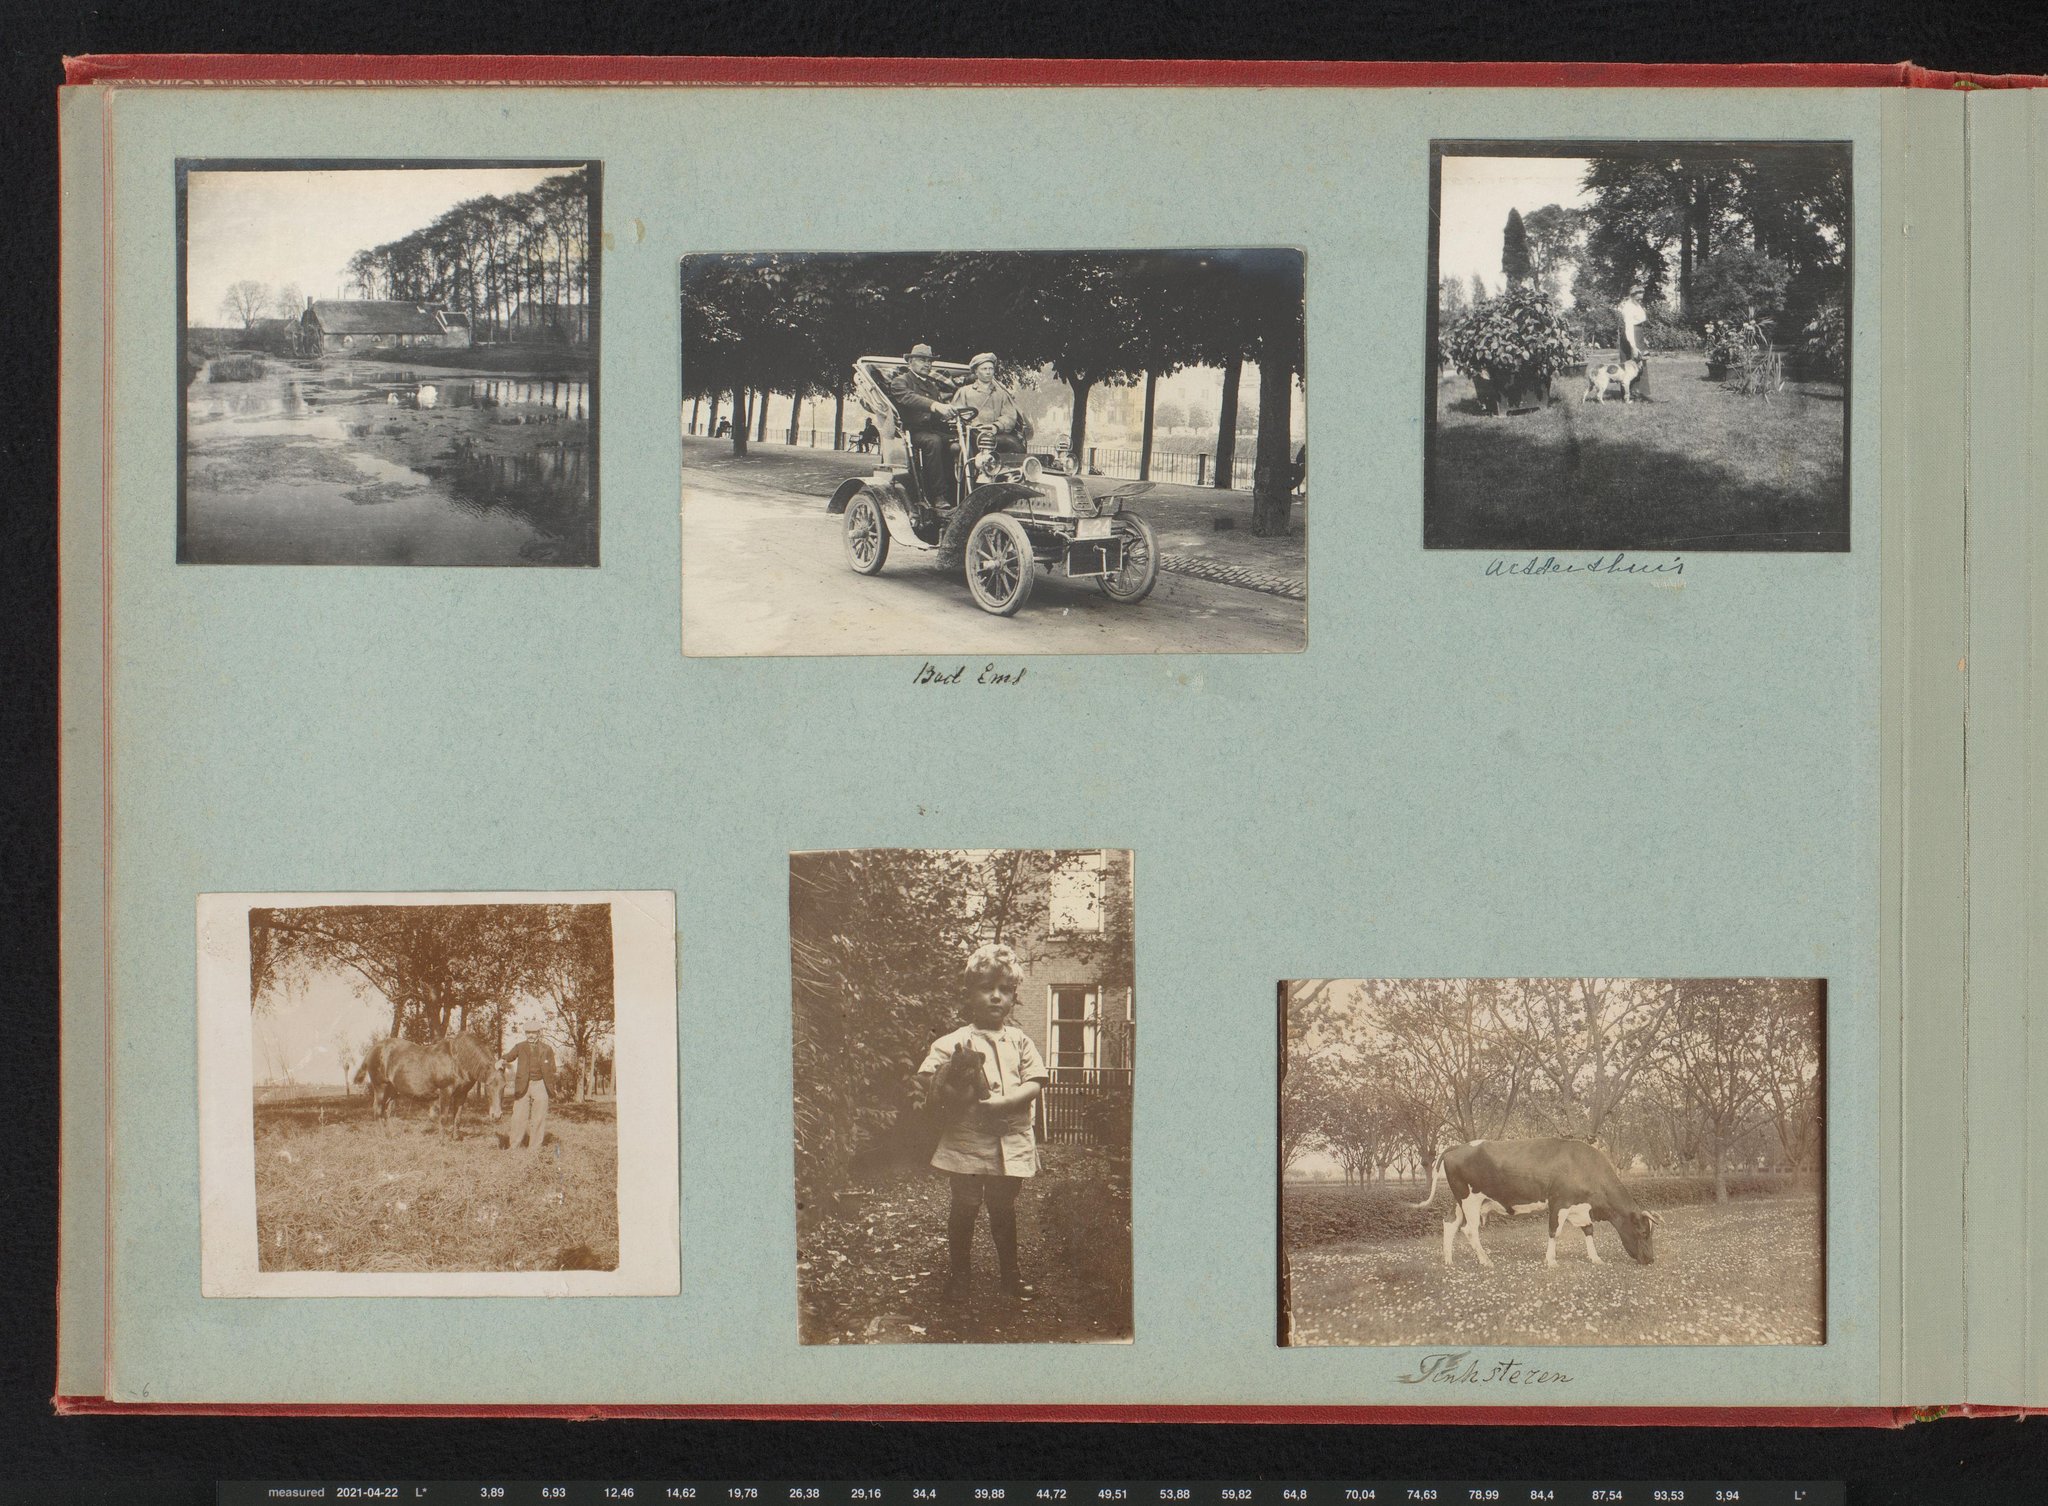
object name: photograph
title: Taferelen in een tuin en in een weiland met leden van de familie Graswinckel, midden boven twee mensen in een auto in Bad Ems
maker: Anonymous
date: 1913-1915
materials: paper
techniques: gelatin silver print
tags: meadow, pasture, automobile, farm (building)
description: Deze foto's zijn onderdeel van een album.